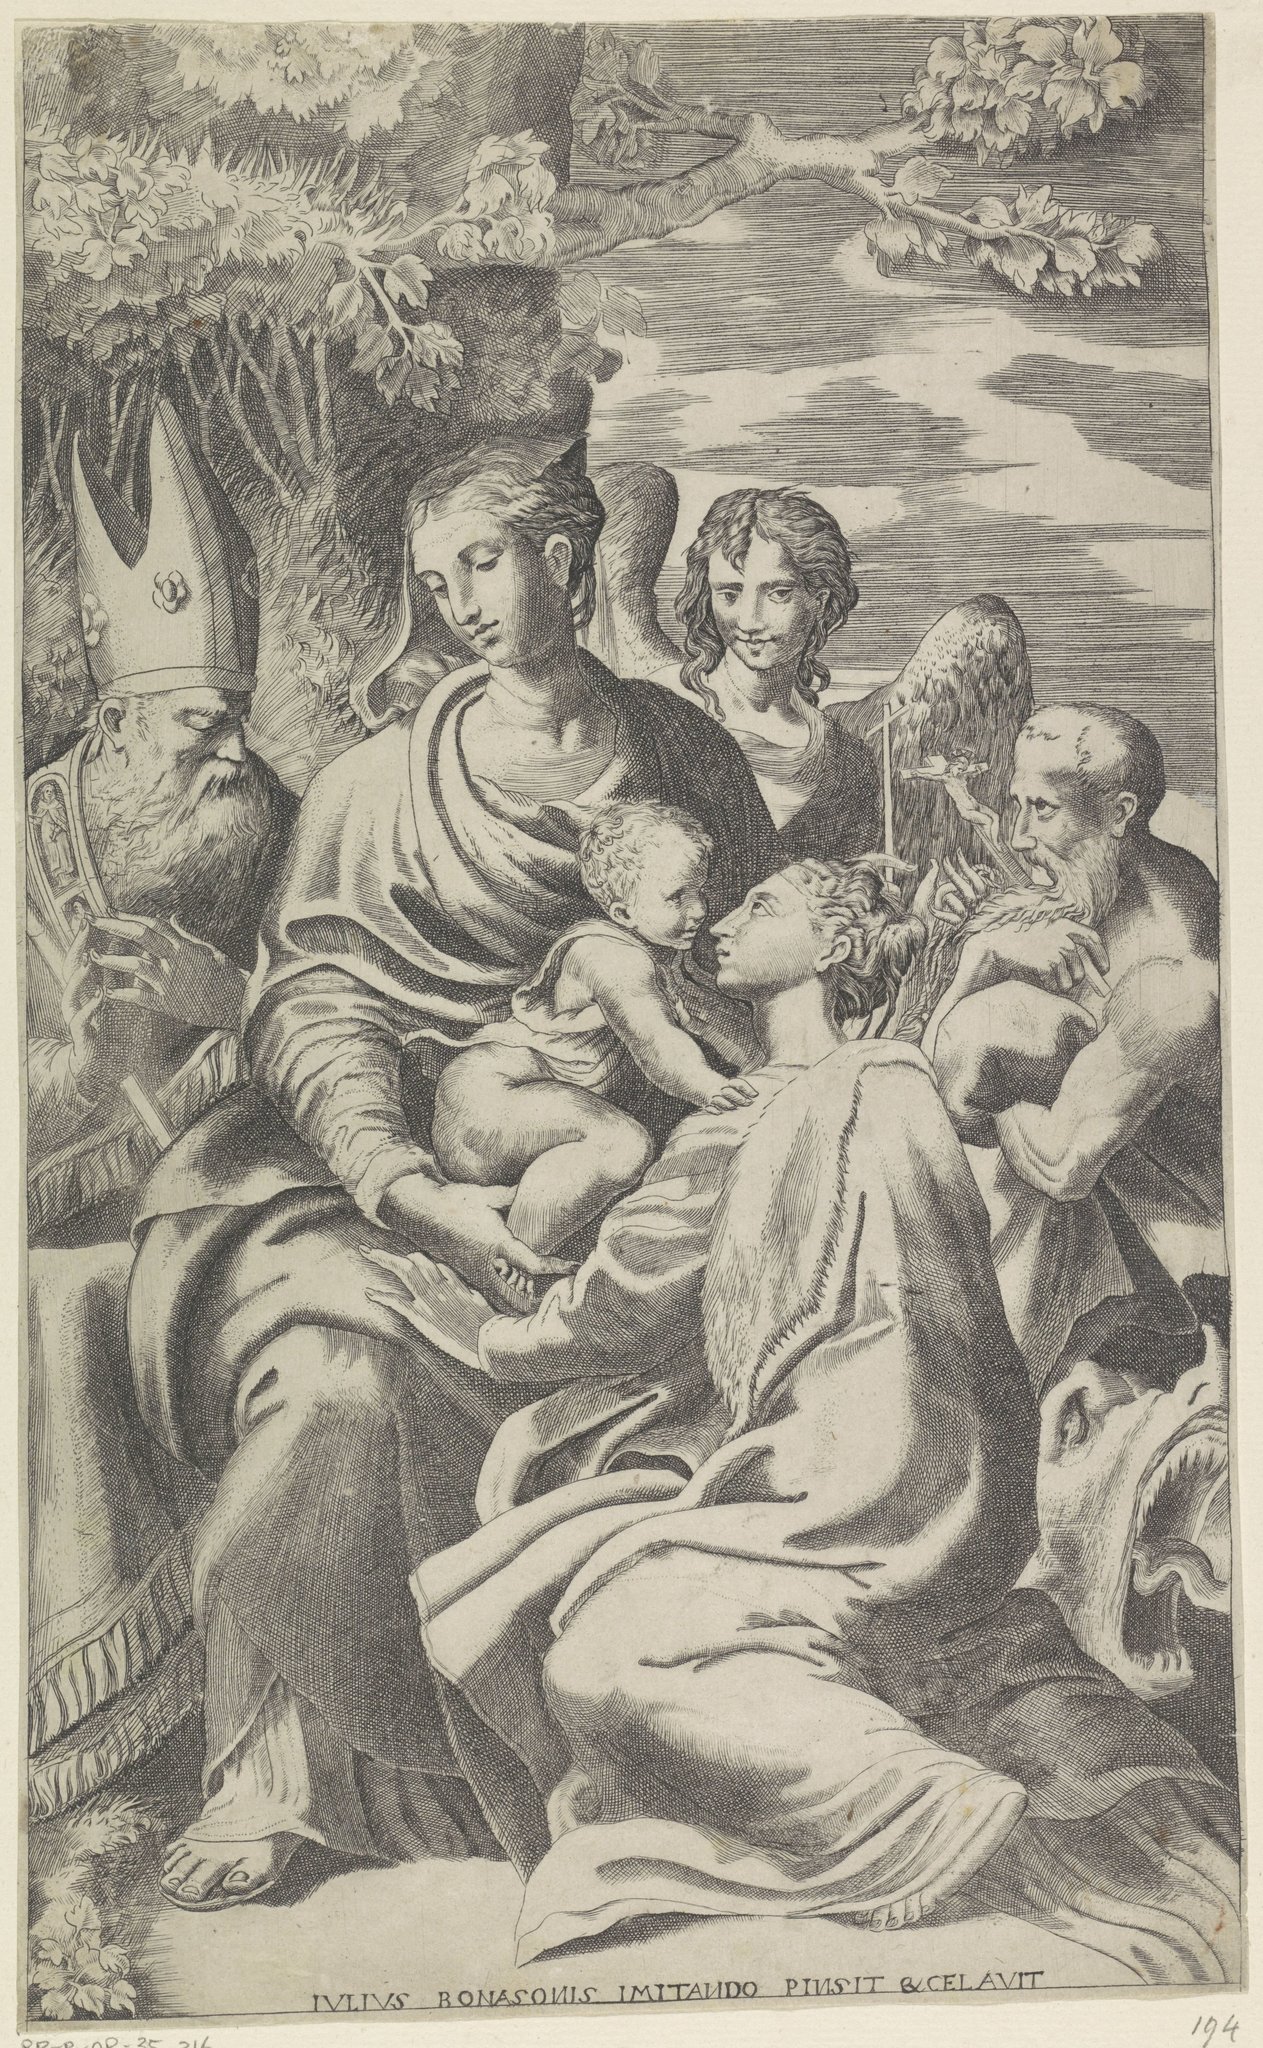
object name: print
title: Maria met het Christuskind en heiligen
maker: giulio bonasone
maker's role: painter, print maker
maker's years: 1510-1576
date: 1501-1580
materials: paper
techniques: engraving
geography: italy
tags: benedict of nurcia, abbot of monte cassino and founder of the benedictine order; possible attributes: aspergillum, book, cup (sometimes broken), raven with loaf, sieve (or tray), madonna: i.e. mary with the christ-child, madonna accompanied by saint(s), the virgin martyr margaret of antioch; possible attributes: cross, crown, dragon (under feet or on chain), (chaplet of) pearls, the monk and hermit jerome (hieronymus); possible attributes: book, cardinal's hat, crucifix, hour-glass, lion, skull, stone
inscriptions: collector's mark: Lugt 240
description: Maria zit met het Christuskind op schoot. Voor haar knielt Margareta van Antiochië met naast haar een draak. Achter Maria staan de heilige Benedictus, een engel en de heilige Hieronymus.